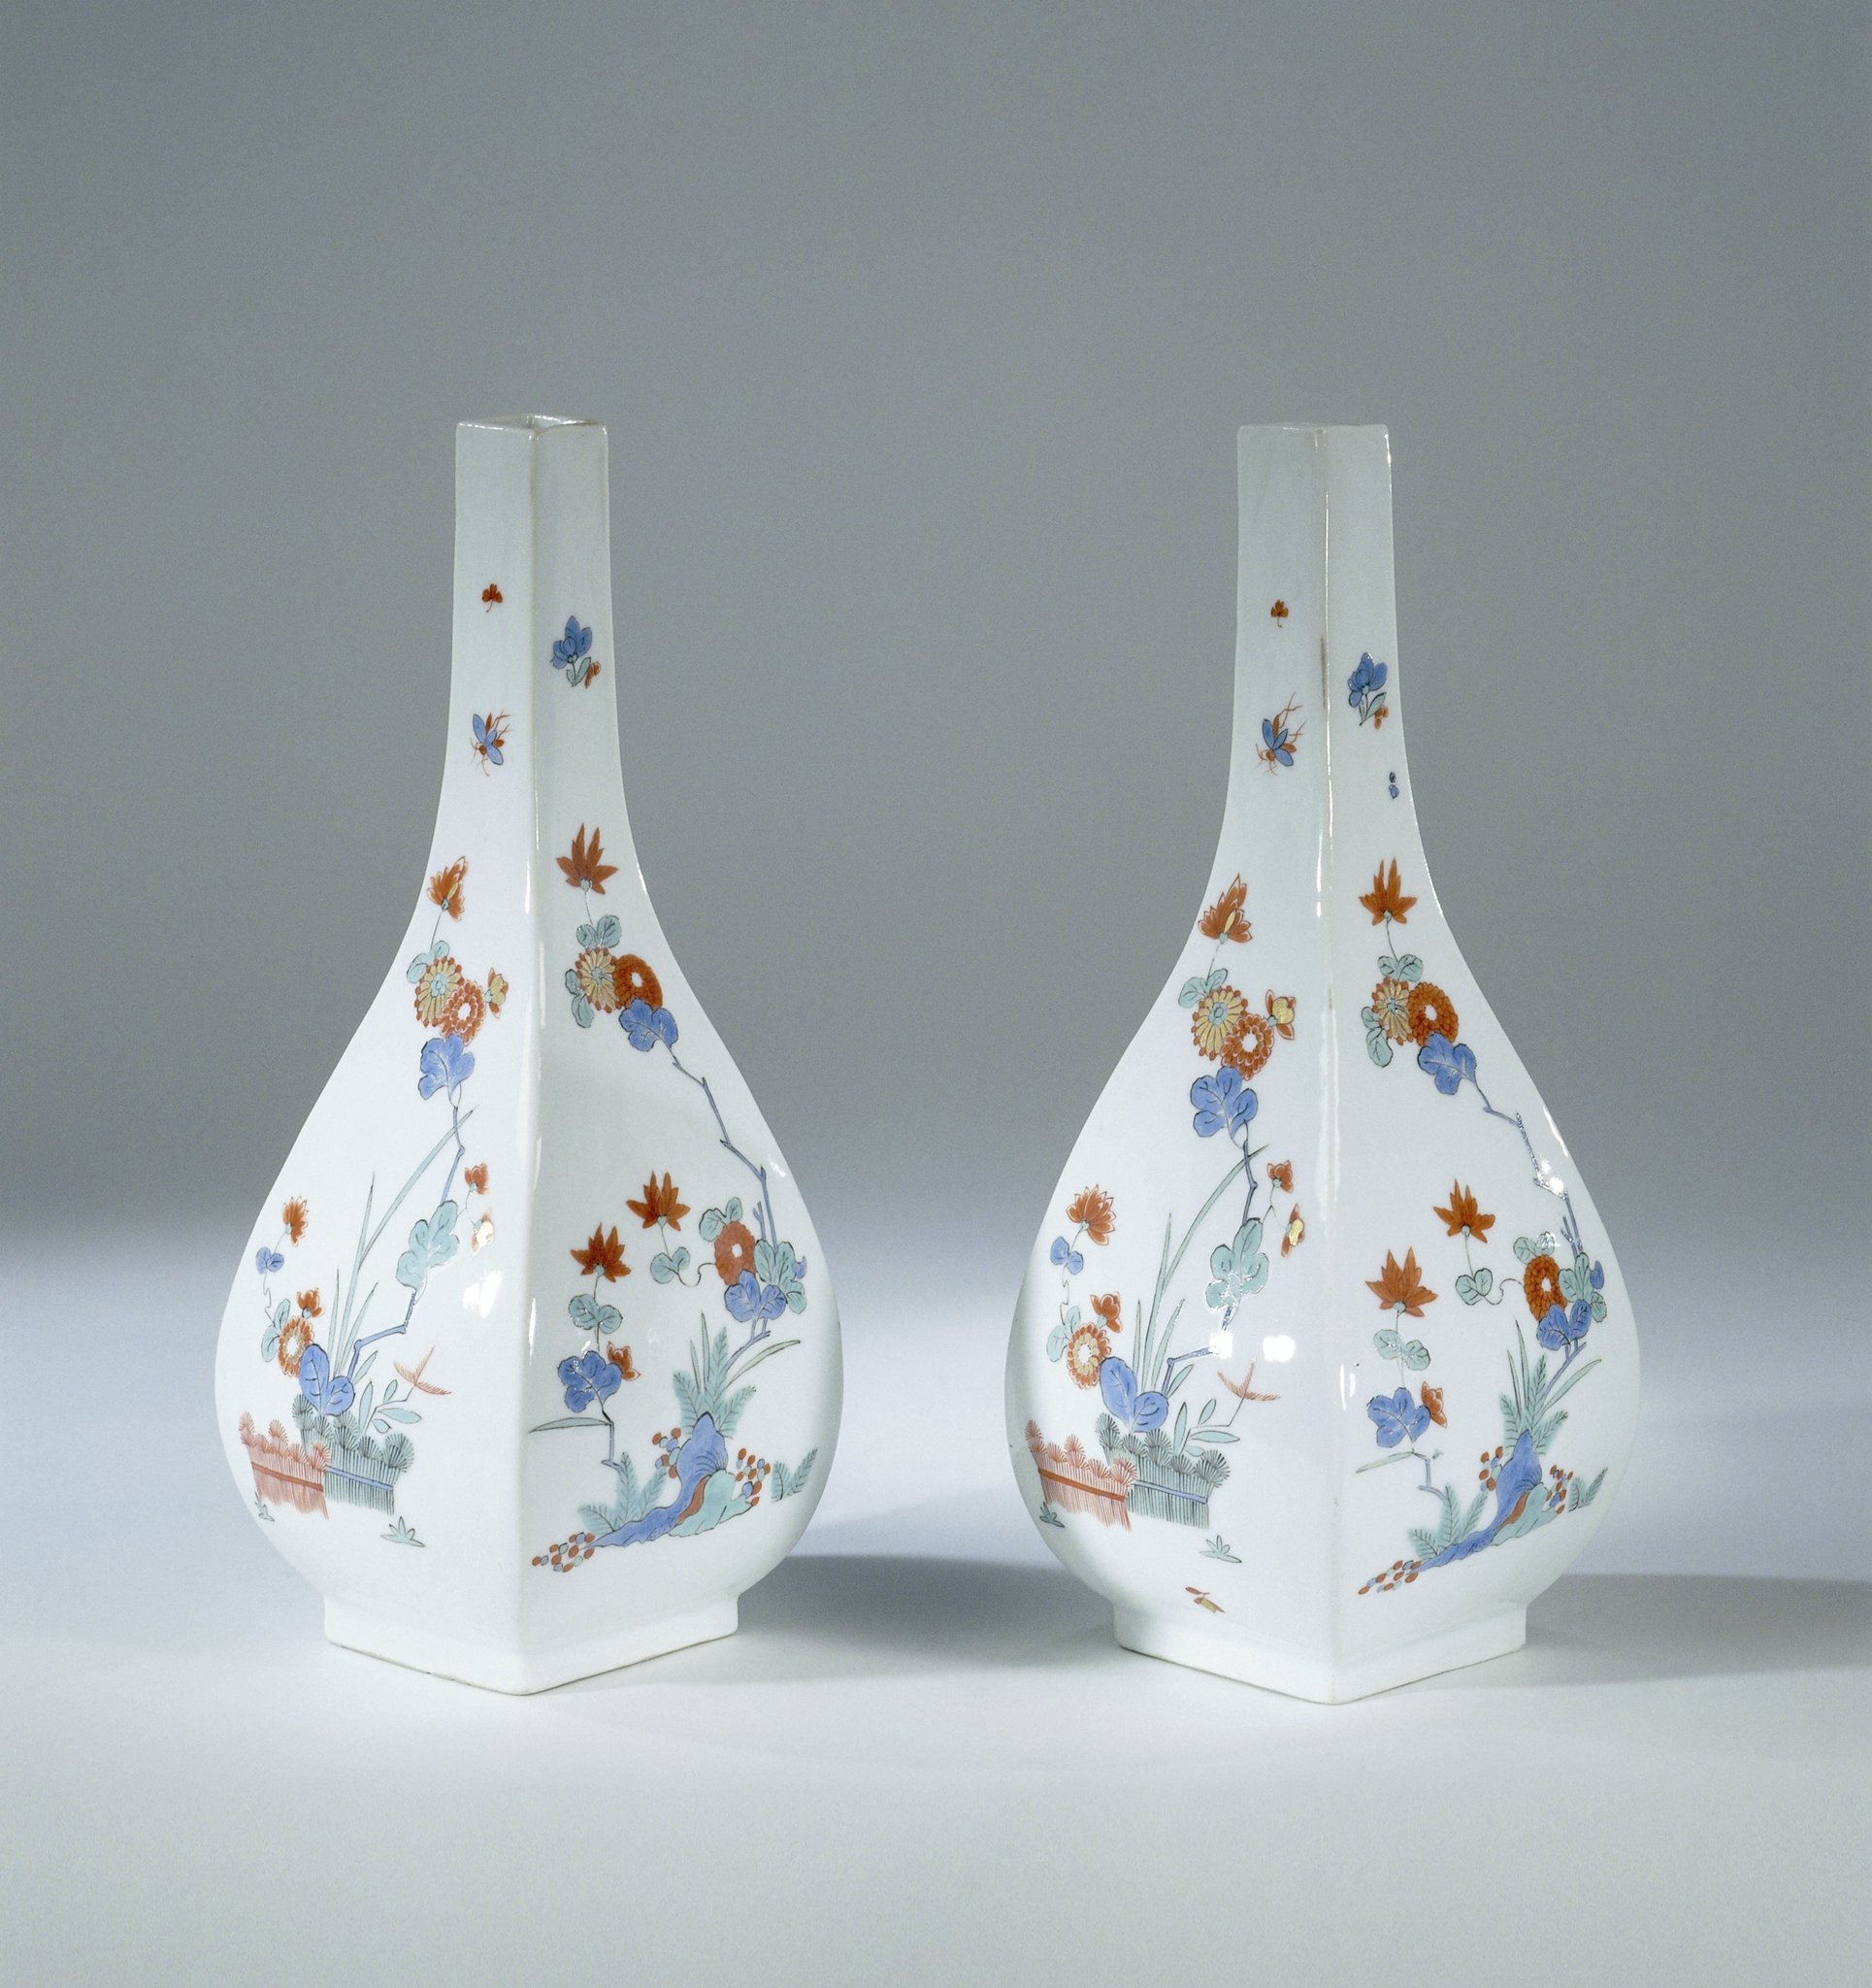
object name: bottle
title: Fles, veelkleurig beschilderd met een Kakiemon-decor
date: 1730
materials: porcelain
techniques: painted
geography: meissen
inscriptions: mold mark, factory mark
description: Pair of vases. Meissen, c. 1725 - 1735.